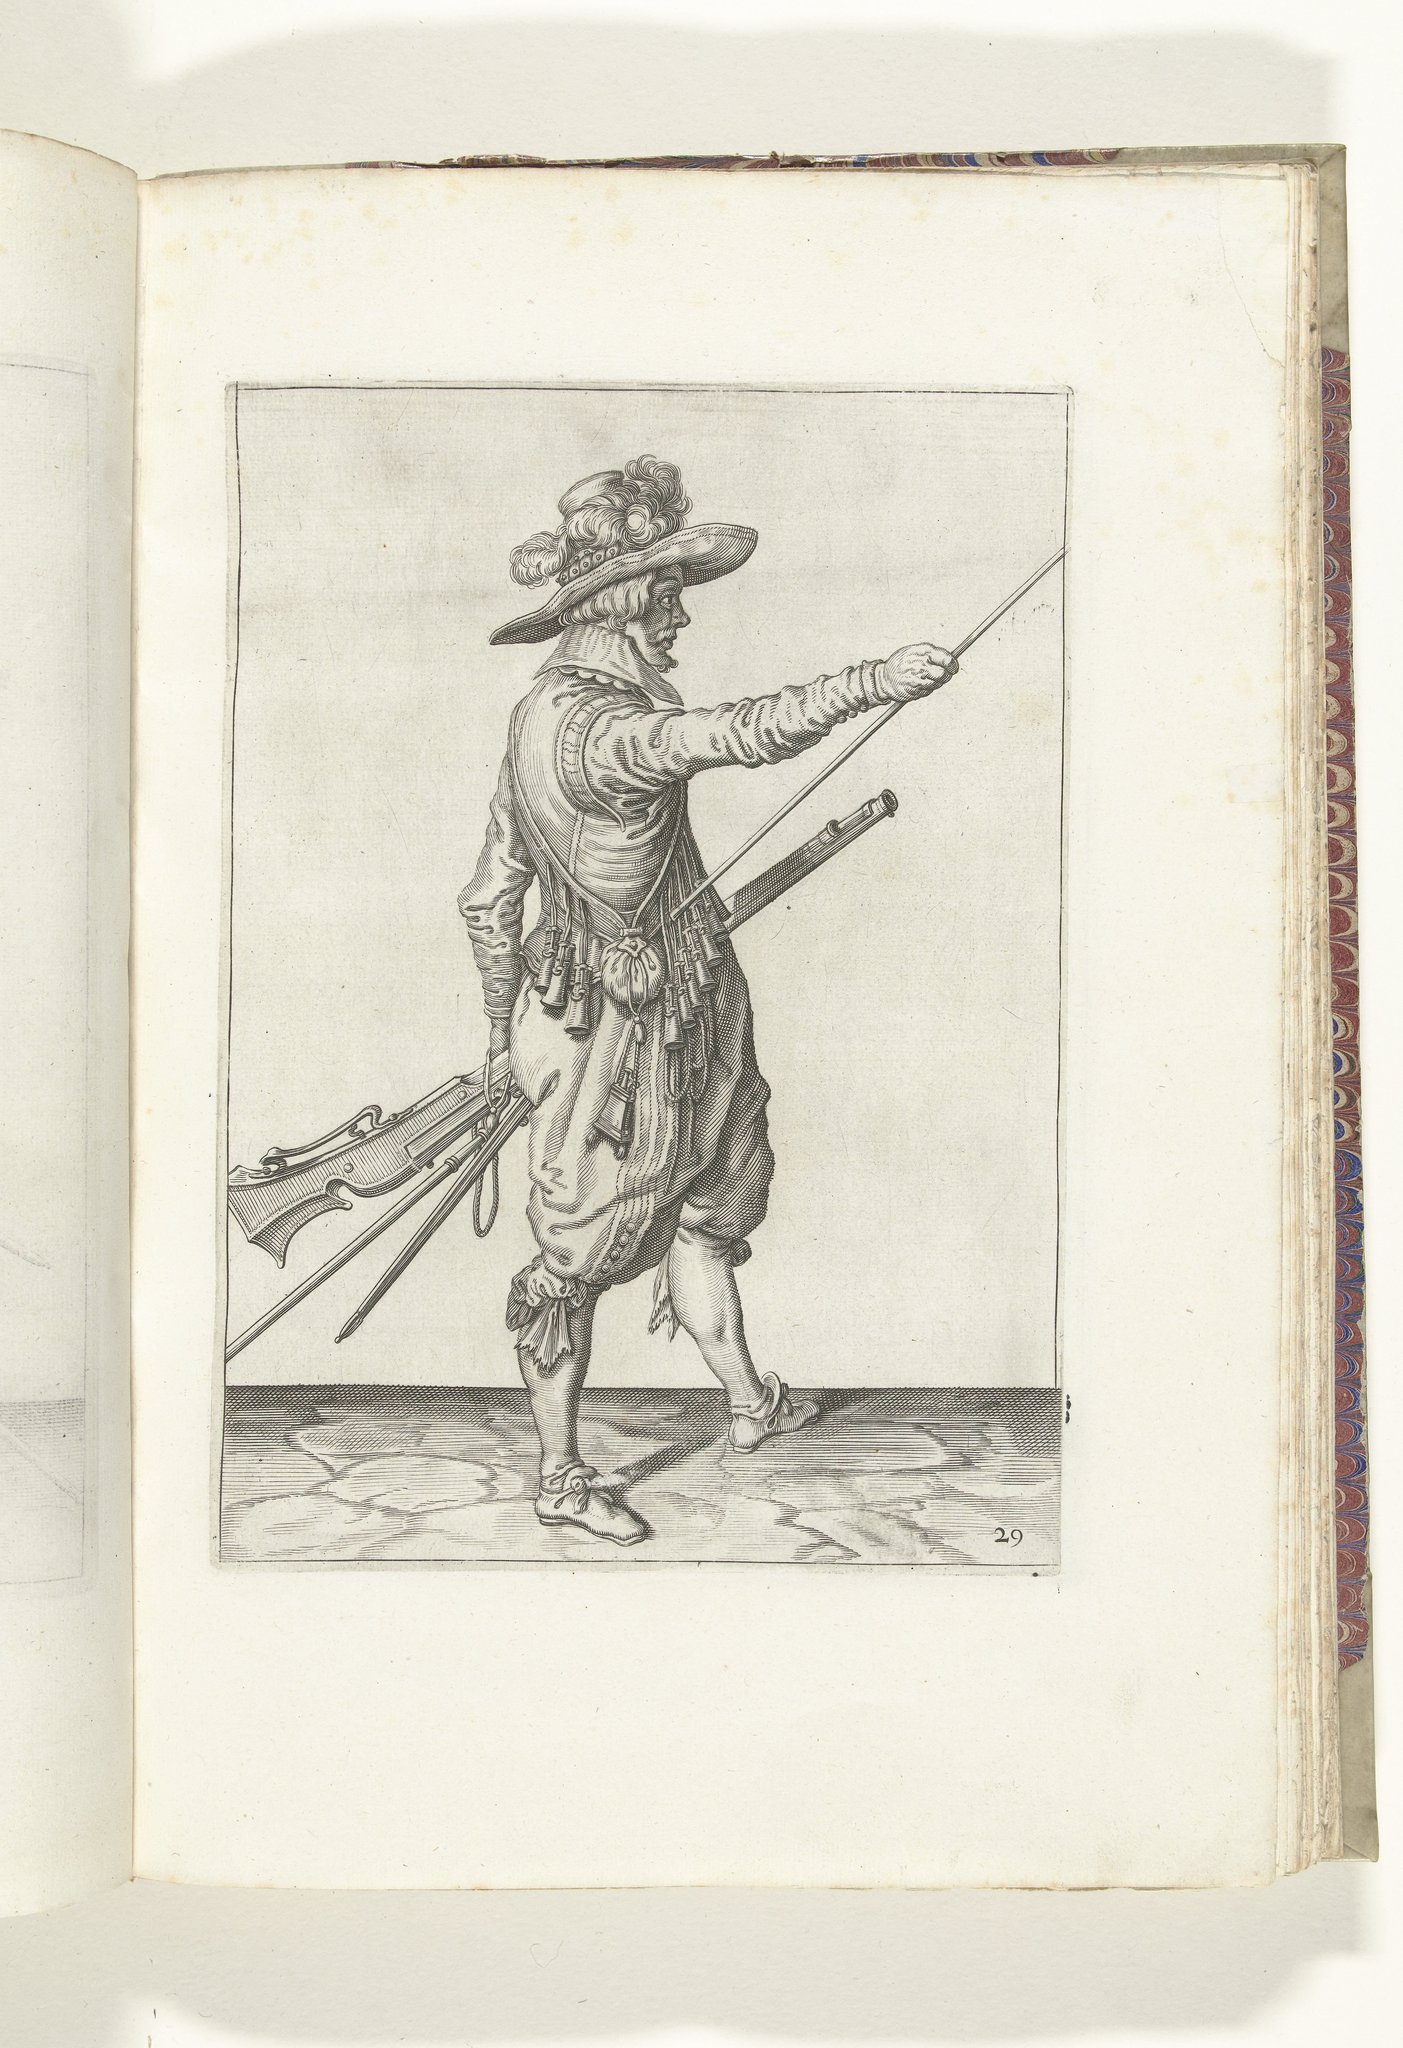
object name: print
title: Soldaat met een musket die zijn rechterhand naar het uiteinde van zijn laadstok schuift (nr. 29), ca. 1600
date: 1597-1607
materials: paper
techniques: engraving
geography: amsterdam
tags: the hague, maurice (prince of orange), handling of weapons ~ military training, weapons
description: Een soldaat, ten voeten uit, naar rechts, die met zijn linkerhand bij zijn linkerdijbeen een musket (een bepaald type vuurwapen) vasthoudt en zijn rechterhand naar het uiteinde brengt van zijn laadstok, die hij tegen zijn rechterzij laat steunen (nr. 29), ca. 1600. In zijn linkerhand behalve het musket ook een lont; aan zijn linkerpols een furket (musketvork). Plaat 29 in de instructies voor het hanteren van het musket: Corte onderrechtinghe op de figuerlicke afbeeldinghe, soo veel aengaet het recht ghebruyck van Musquet. Onderdeel van de illustraties in: J. de Gheyn, Wapenhandelinghe van Roers Musquetten ende spiessen, Amsterdam, 1608. Krijgswezen rond 1600.